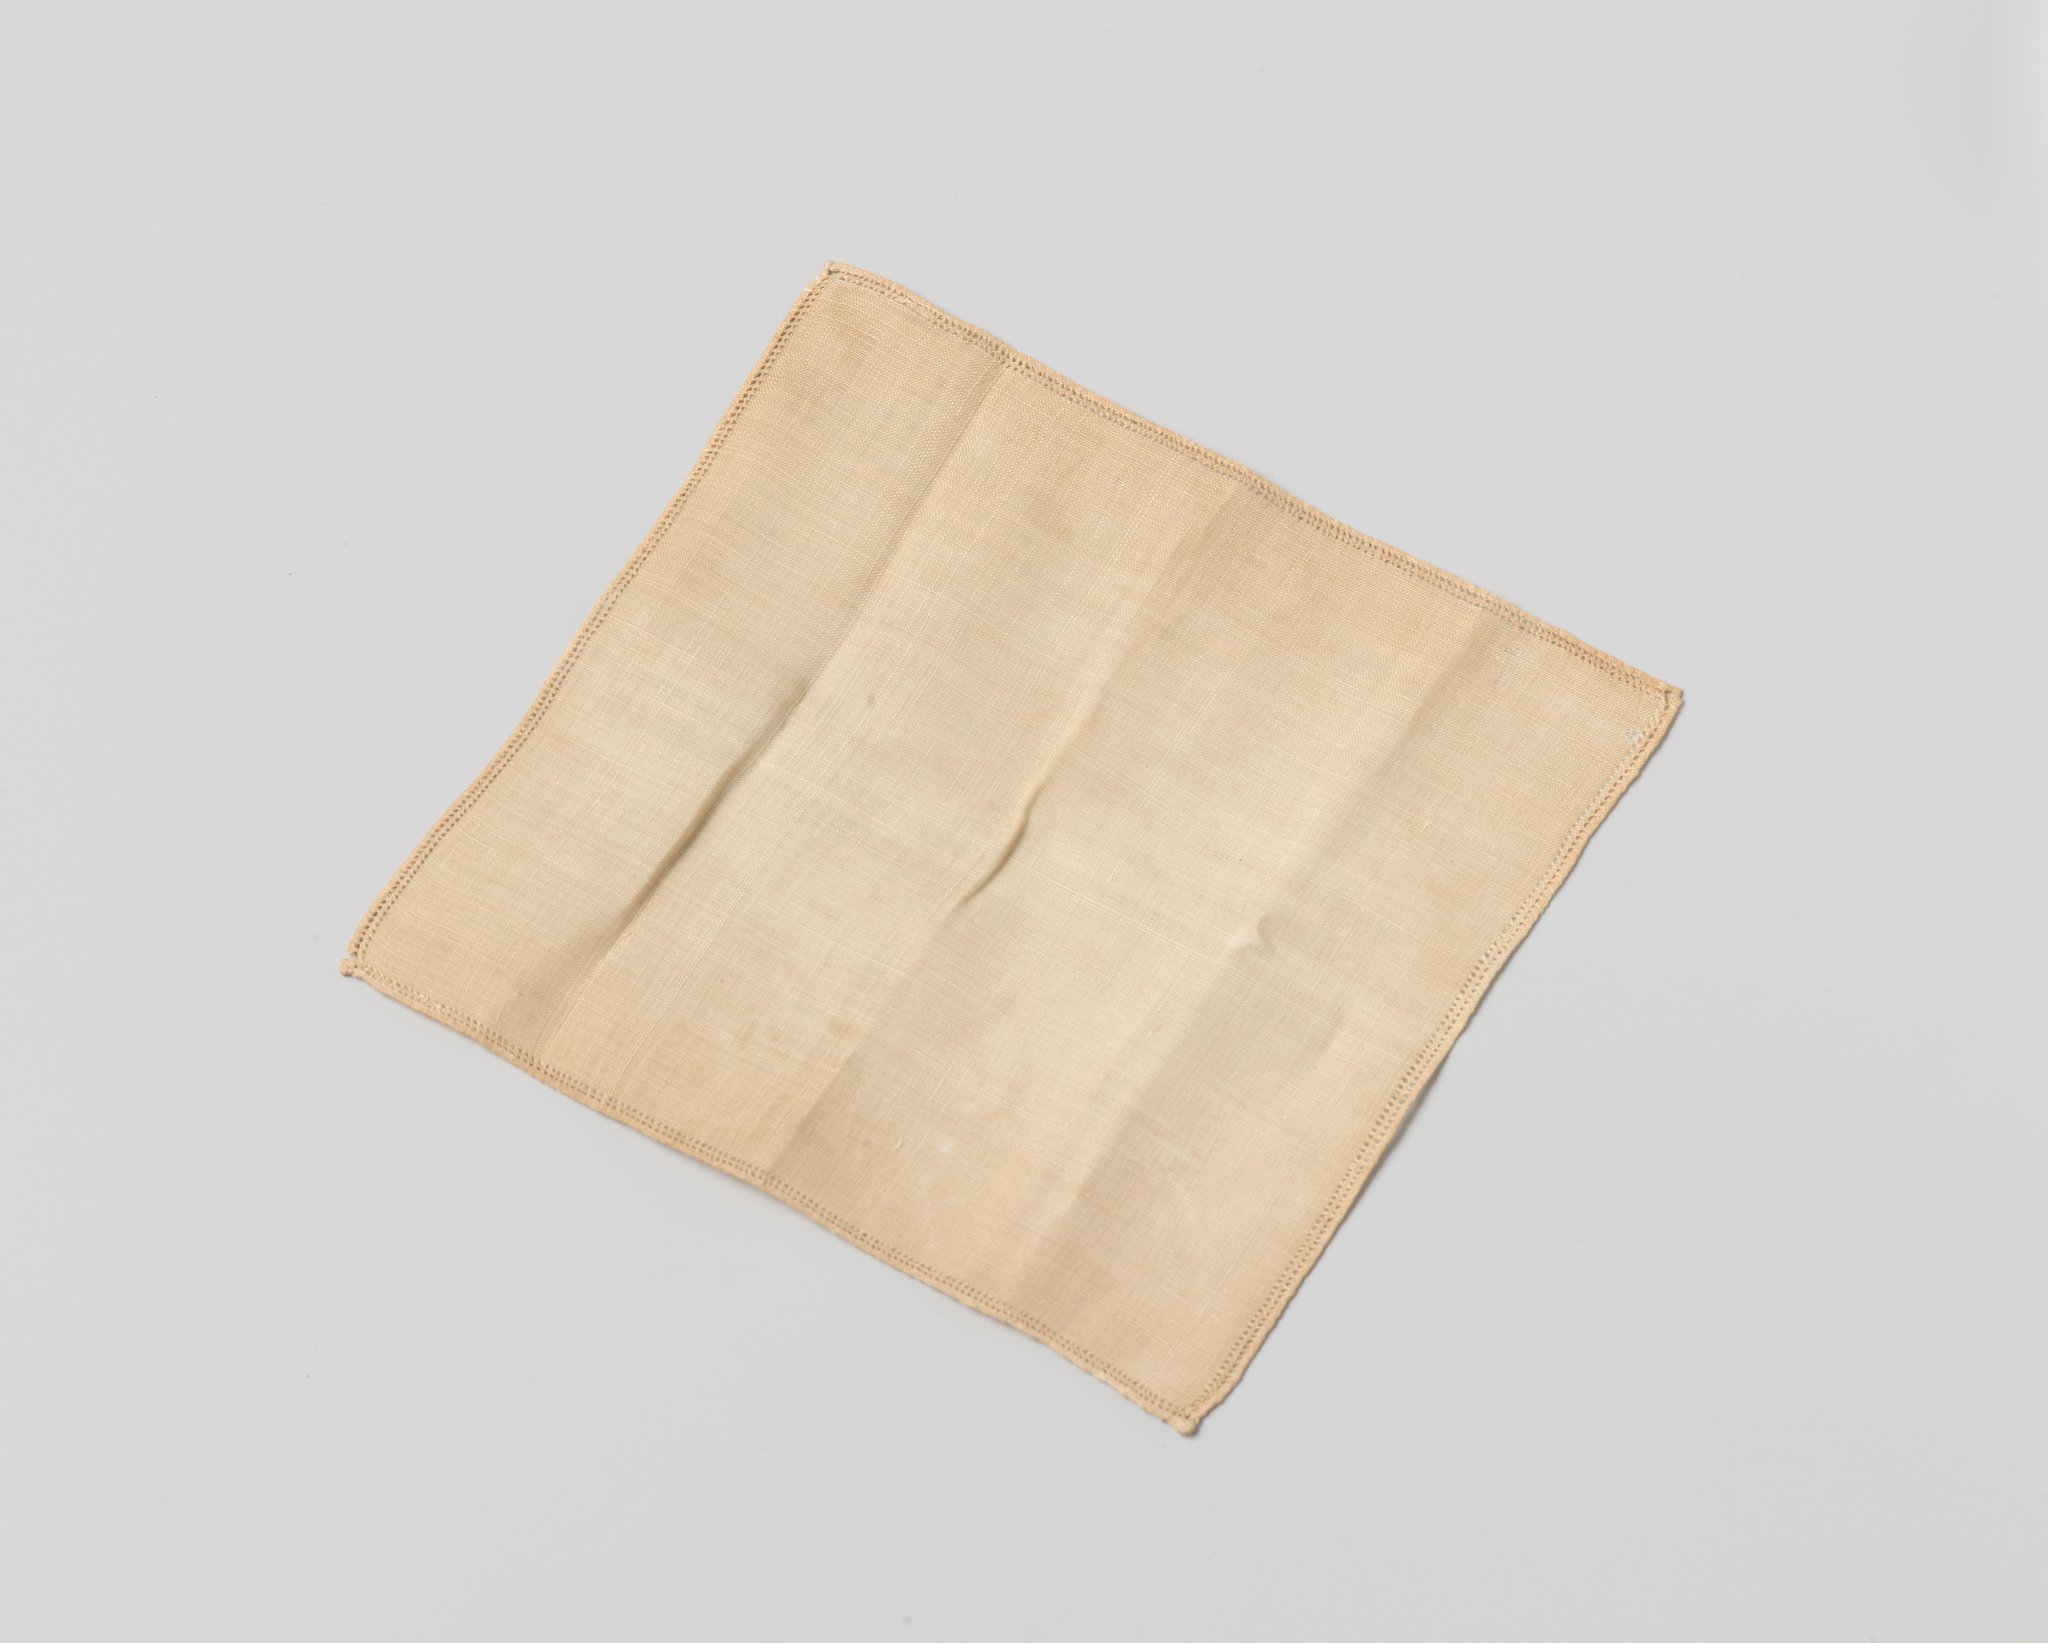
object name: miniature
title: Tafelkleed met opengewerkte zoom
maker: Anonymous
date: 1700-1799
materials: linen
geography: netherlands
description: Een fijnlinnen tafelkleed met opengewerkte zoom.